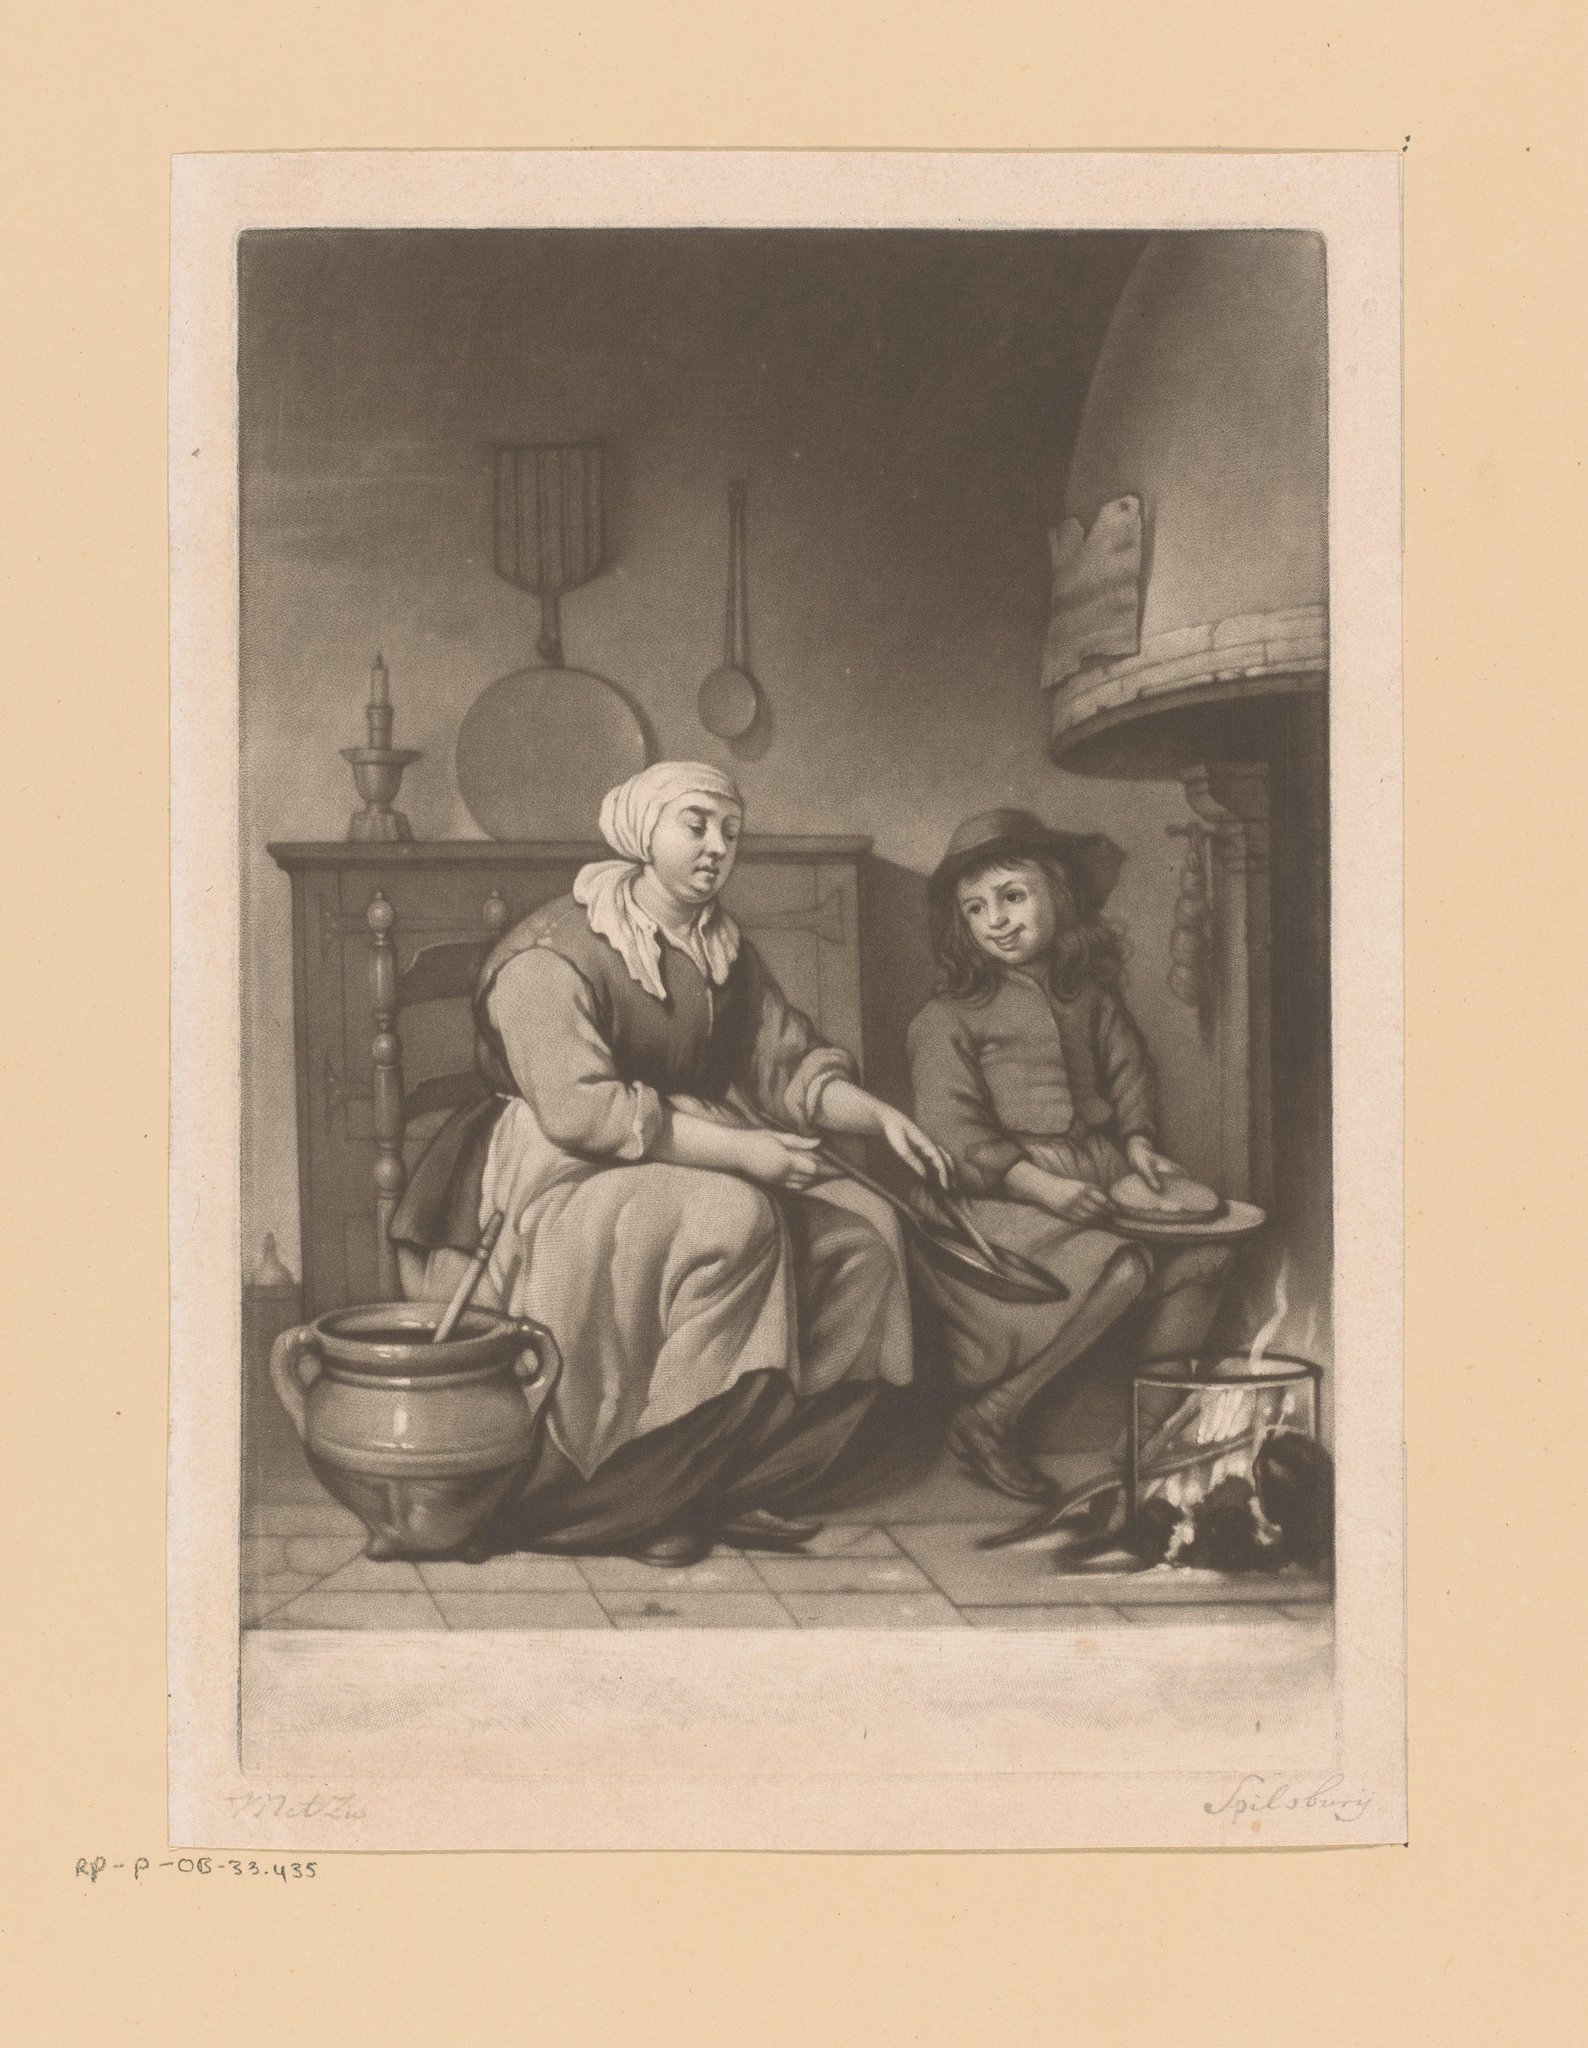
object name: print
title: Interieur met koekenbakster en jongen bij een haard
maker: jonathan spilsbury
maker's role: print maker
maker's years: 1737-1812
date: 1767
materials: paper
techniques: mezzotint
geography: london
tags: pancakes, hearth and stove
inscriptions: collector's mark: Lugt 240